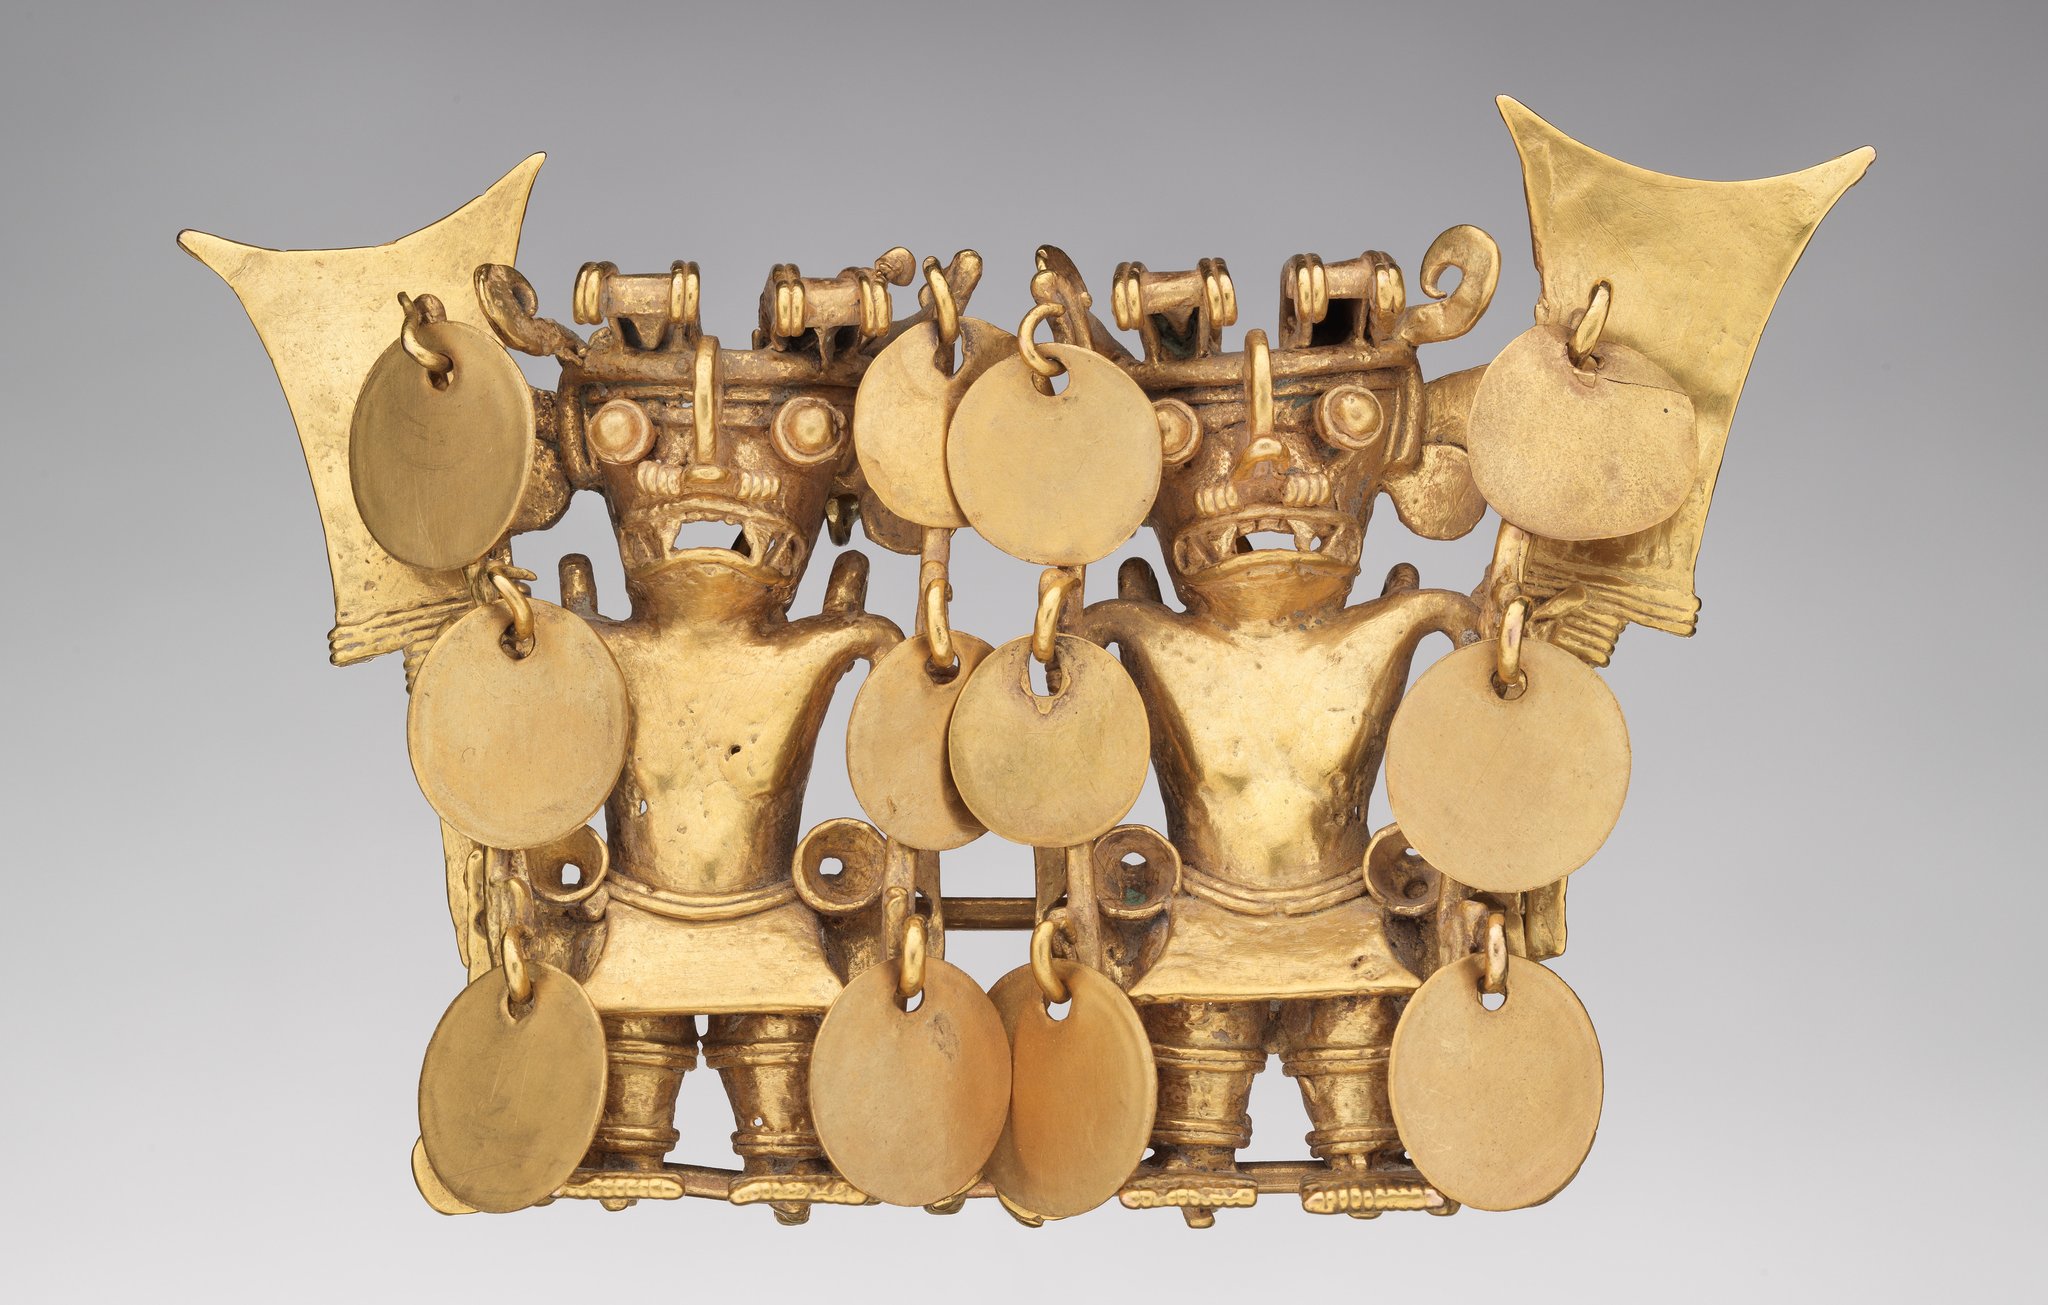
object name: pendant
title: Double Bat-Head Figure Pendant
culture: coclé, parita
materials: gold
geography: panama